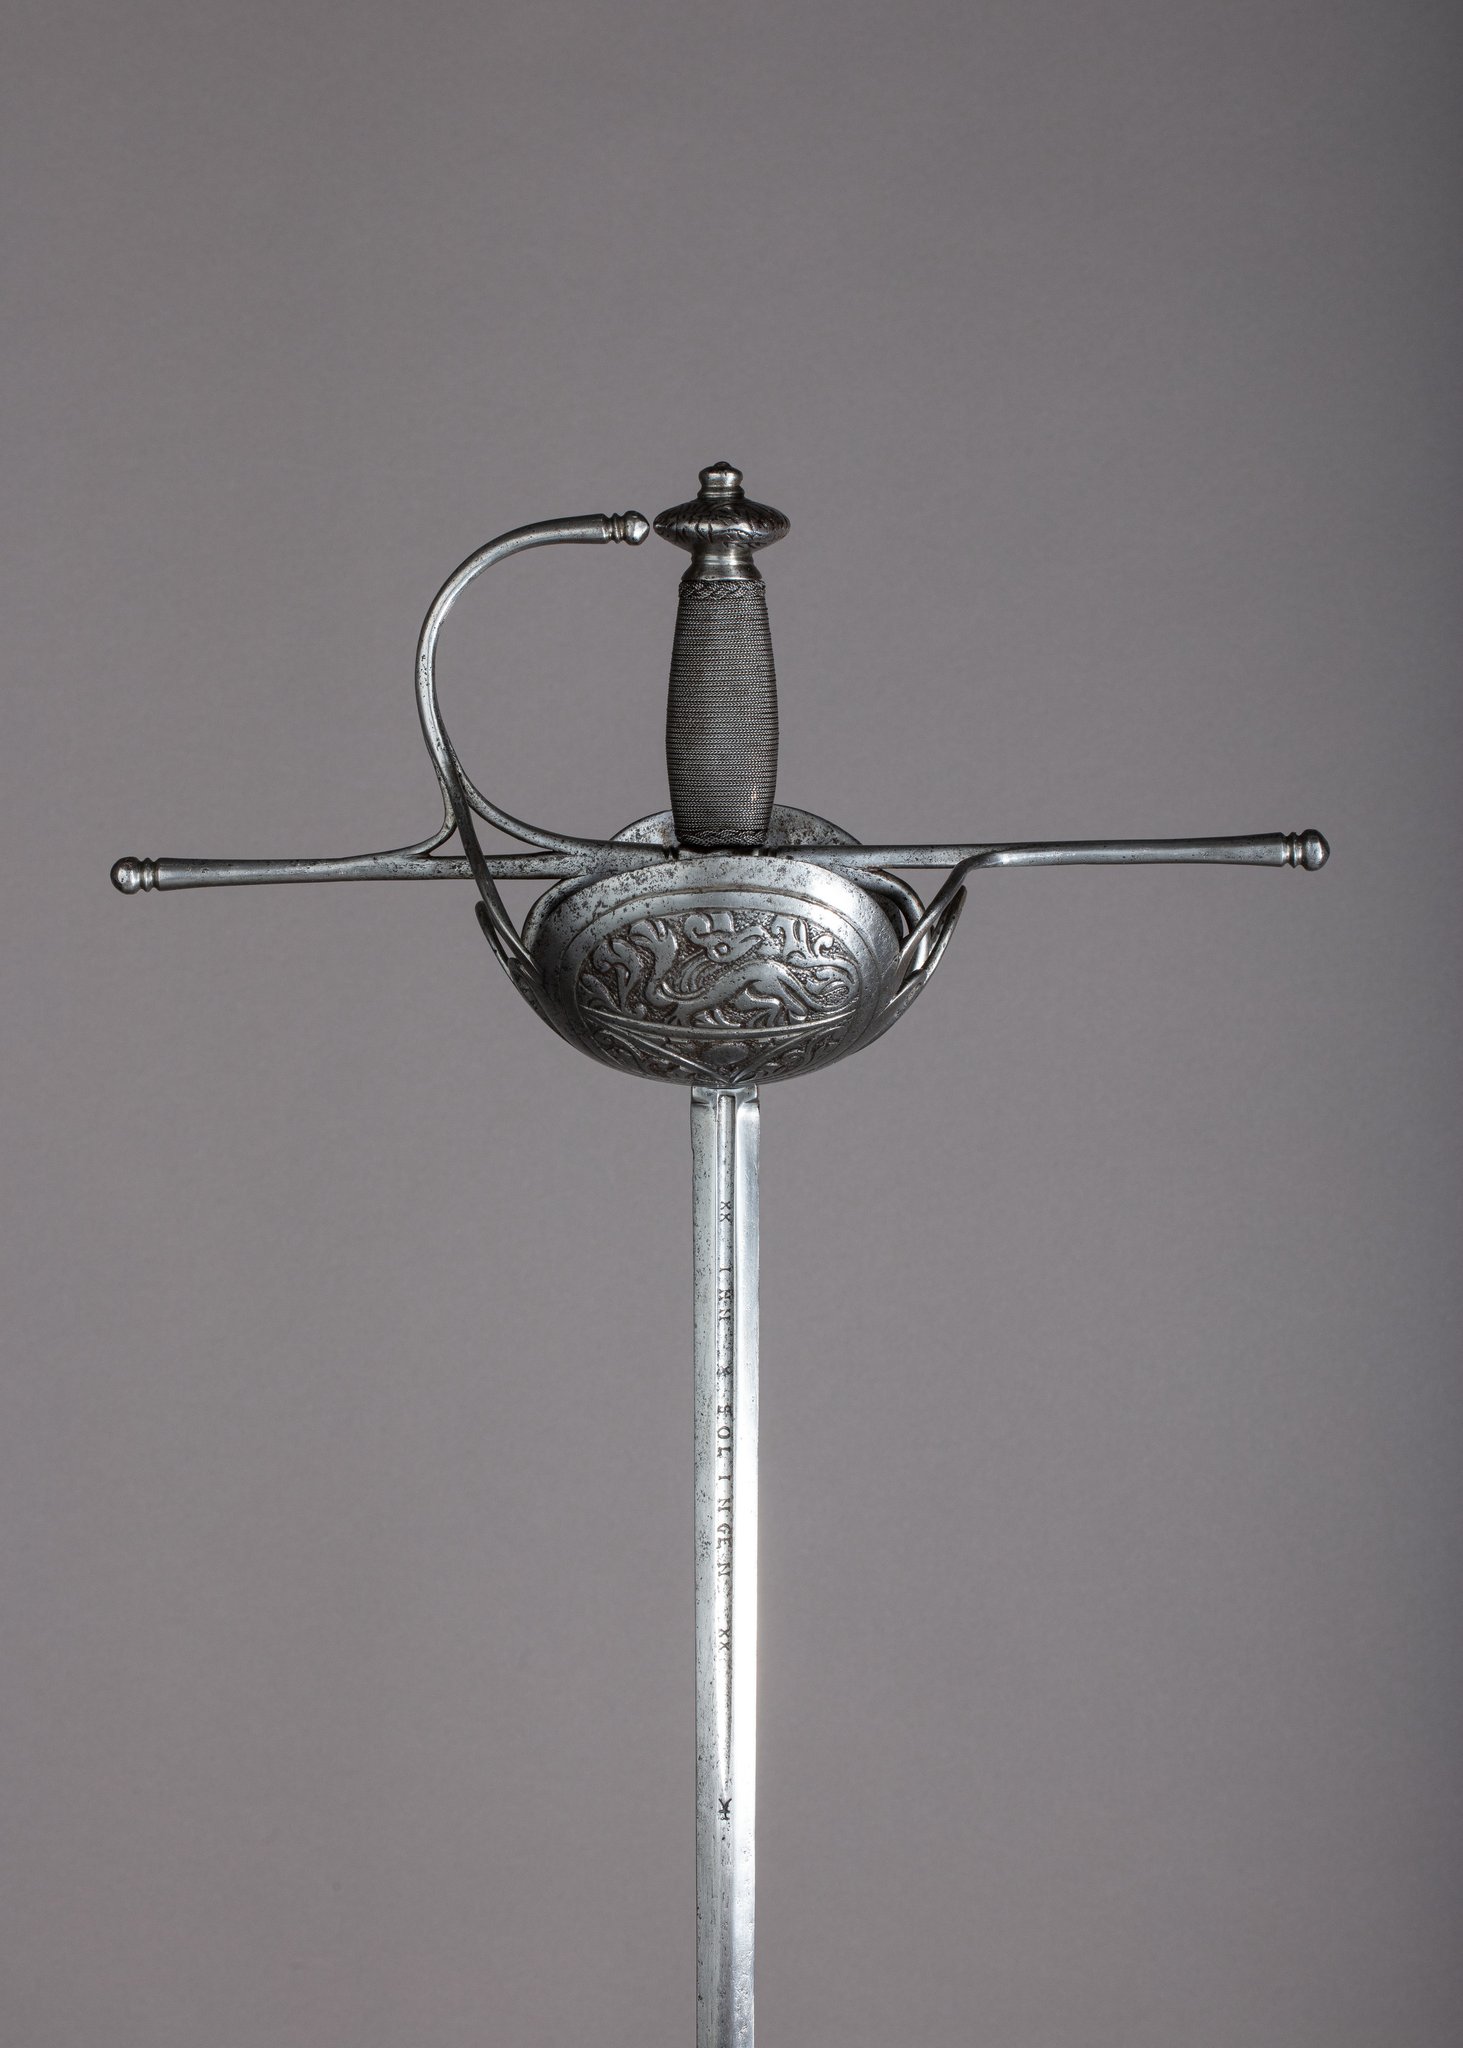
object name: cup hilted rapier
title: Cup-Hilted Rapier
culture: spanish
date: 1601-1700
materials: steel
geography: spain